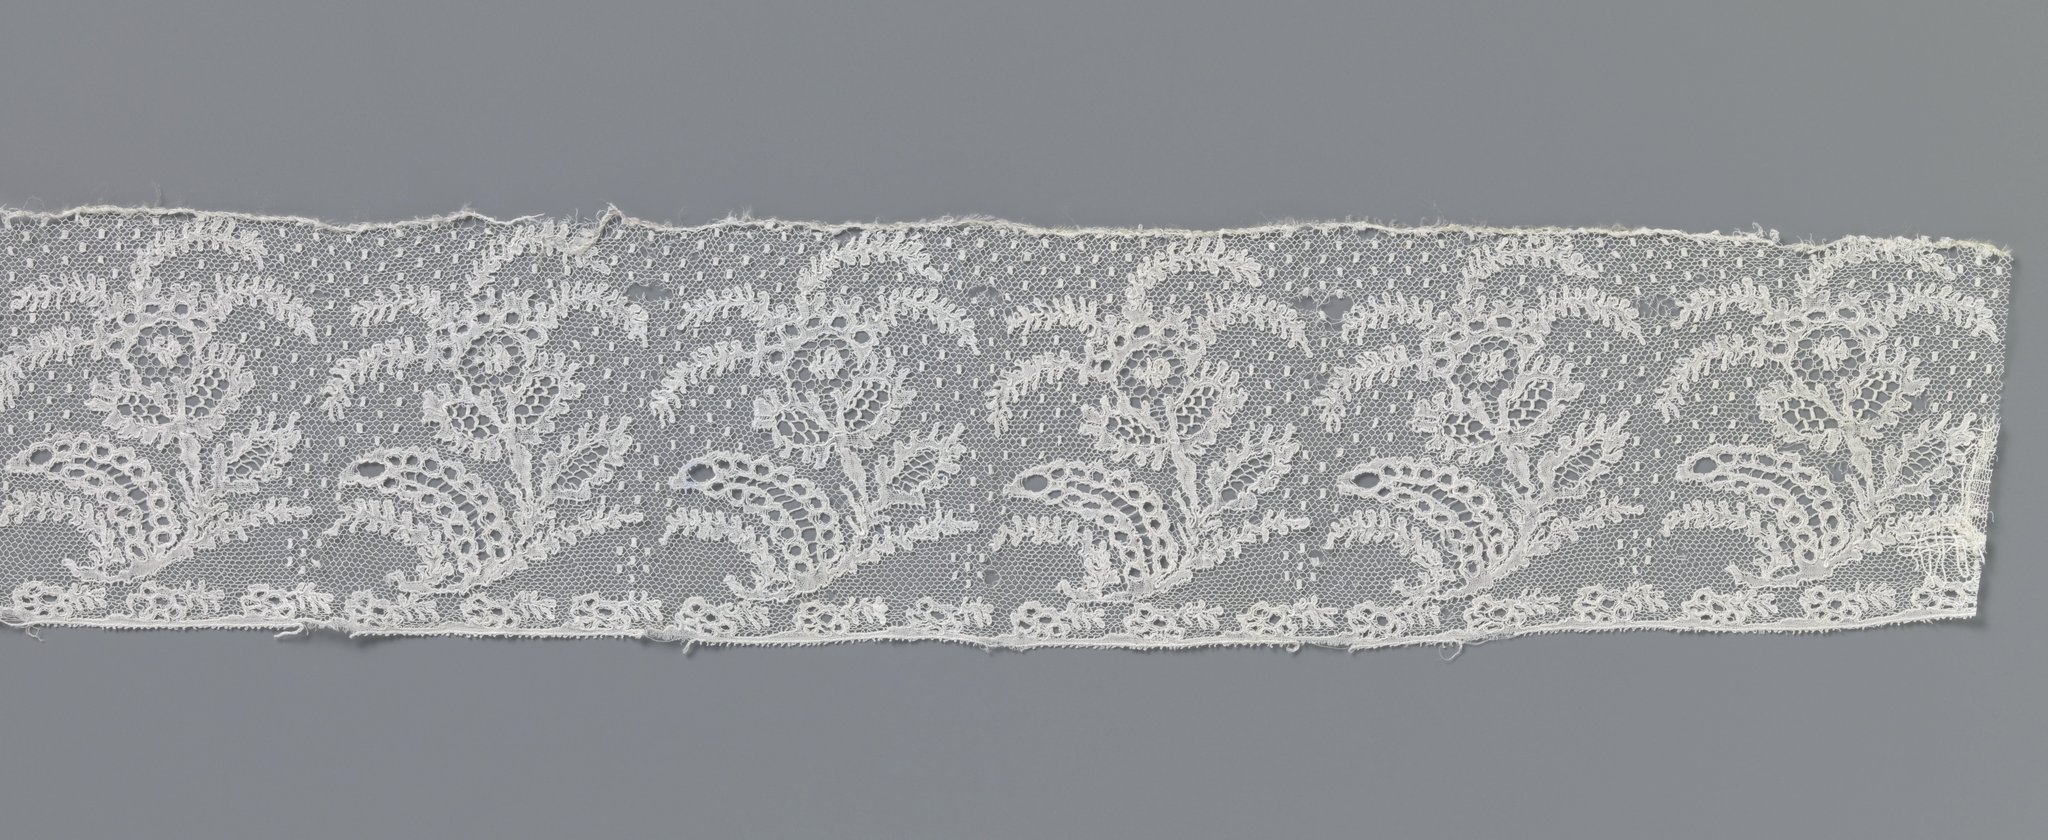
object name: strip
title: Strook kloskant met bloemkelk waaruit vier smalle gevederde pluimen ontspringen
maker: Anonymous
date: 1800-1849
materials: linen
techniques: lace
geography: lille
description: Strook naturelkleurige kloskant: Rijselse kant. Het zich herhalende patroon bestaat uit een gebogen stengel met bladeren en één bloem waaruit vier smalle gevedere pluimen ontspringen. Onder de opeenvolgende bloemen liggen langs de onderzijde van de strook steeds drie eenzijdig gerichte rozetbloempjes, elk met een gevederd blaadje. De motieven zijn met elkaar verbonden door een fijne traliegrond, een tulegrond, die is bezaaid met vierkante moesjes. De motieven zijn gemaakt in linnenslag met veelal grote uitsparingen en dikkere en glimmende contourdraden. In de bloemen en de grootste bladeren zijn siergronden toegepast. De moesjes zijn gemaakt in vormslag. De bovenzijde van de strook is recht afgewerkt. Het gekloste bandje langs de onderzijde is afgewerkt met picots.